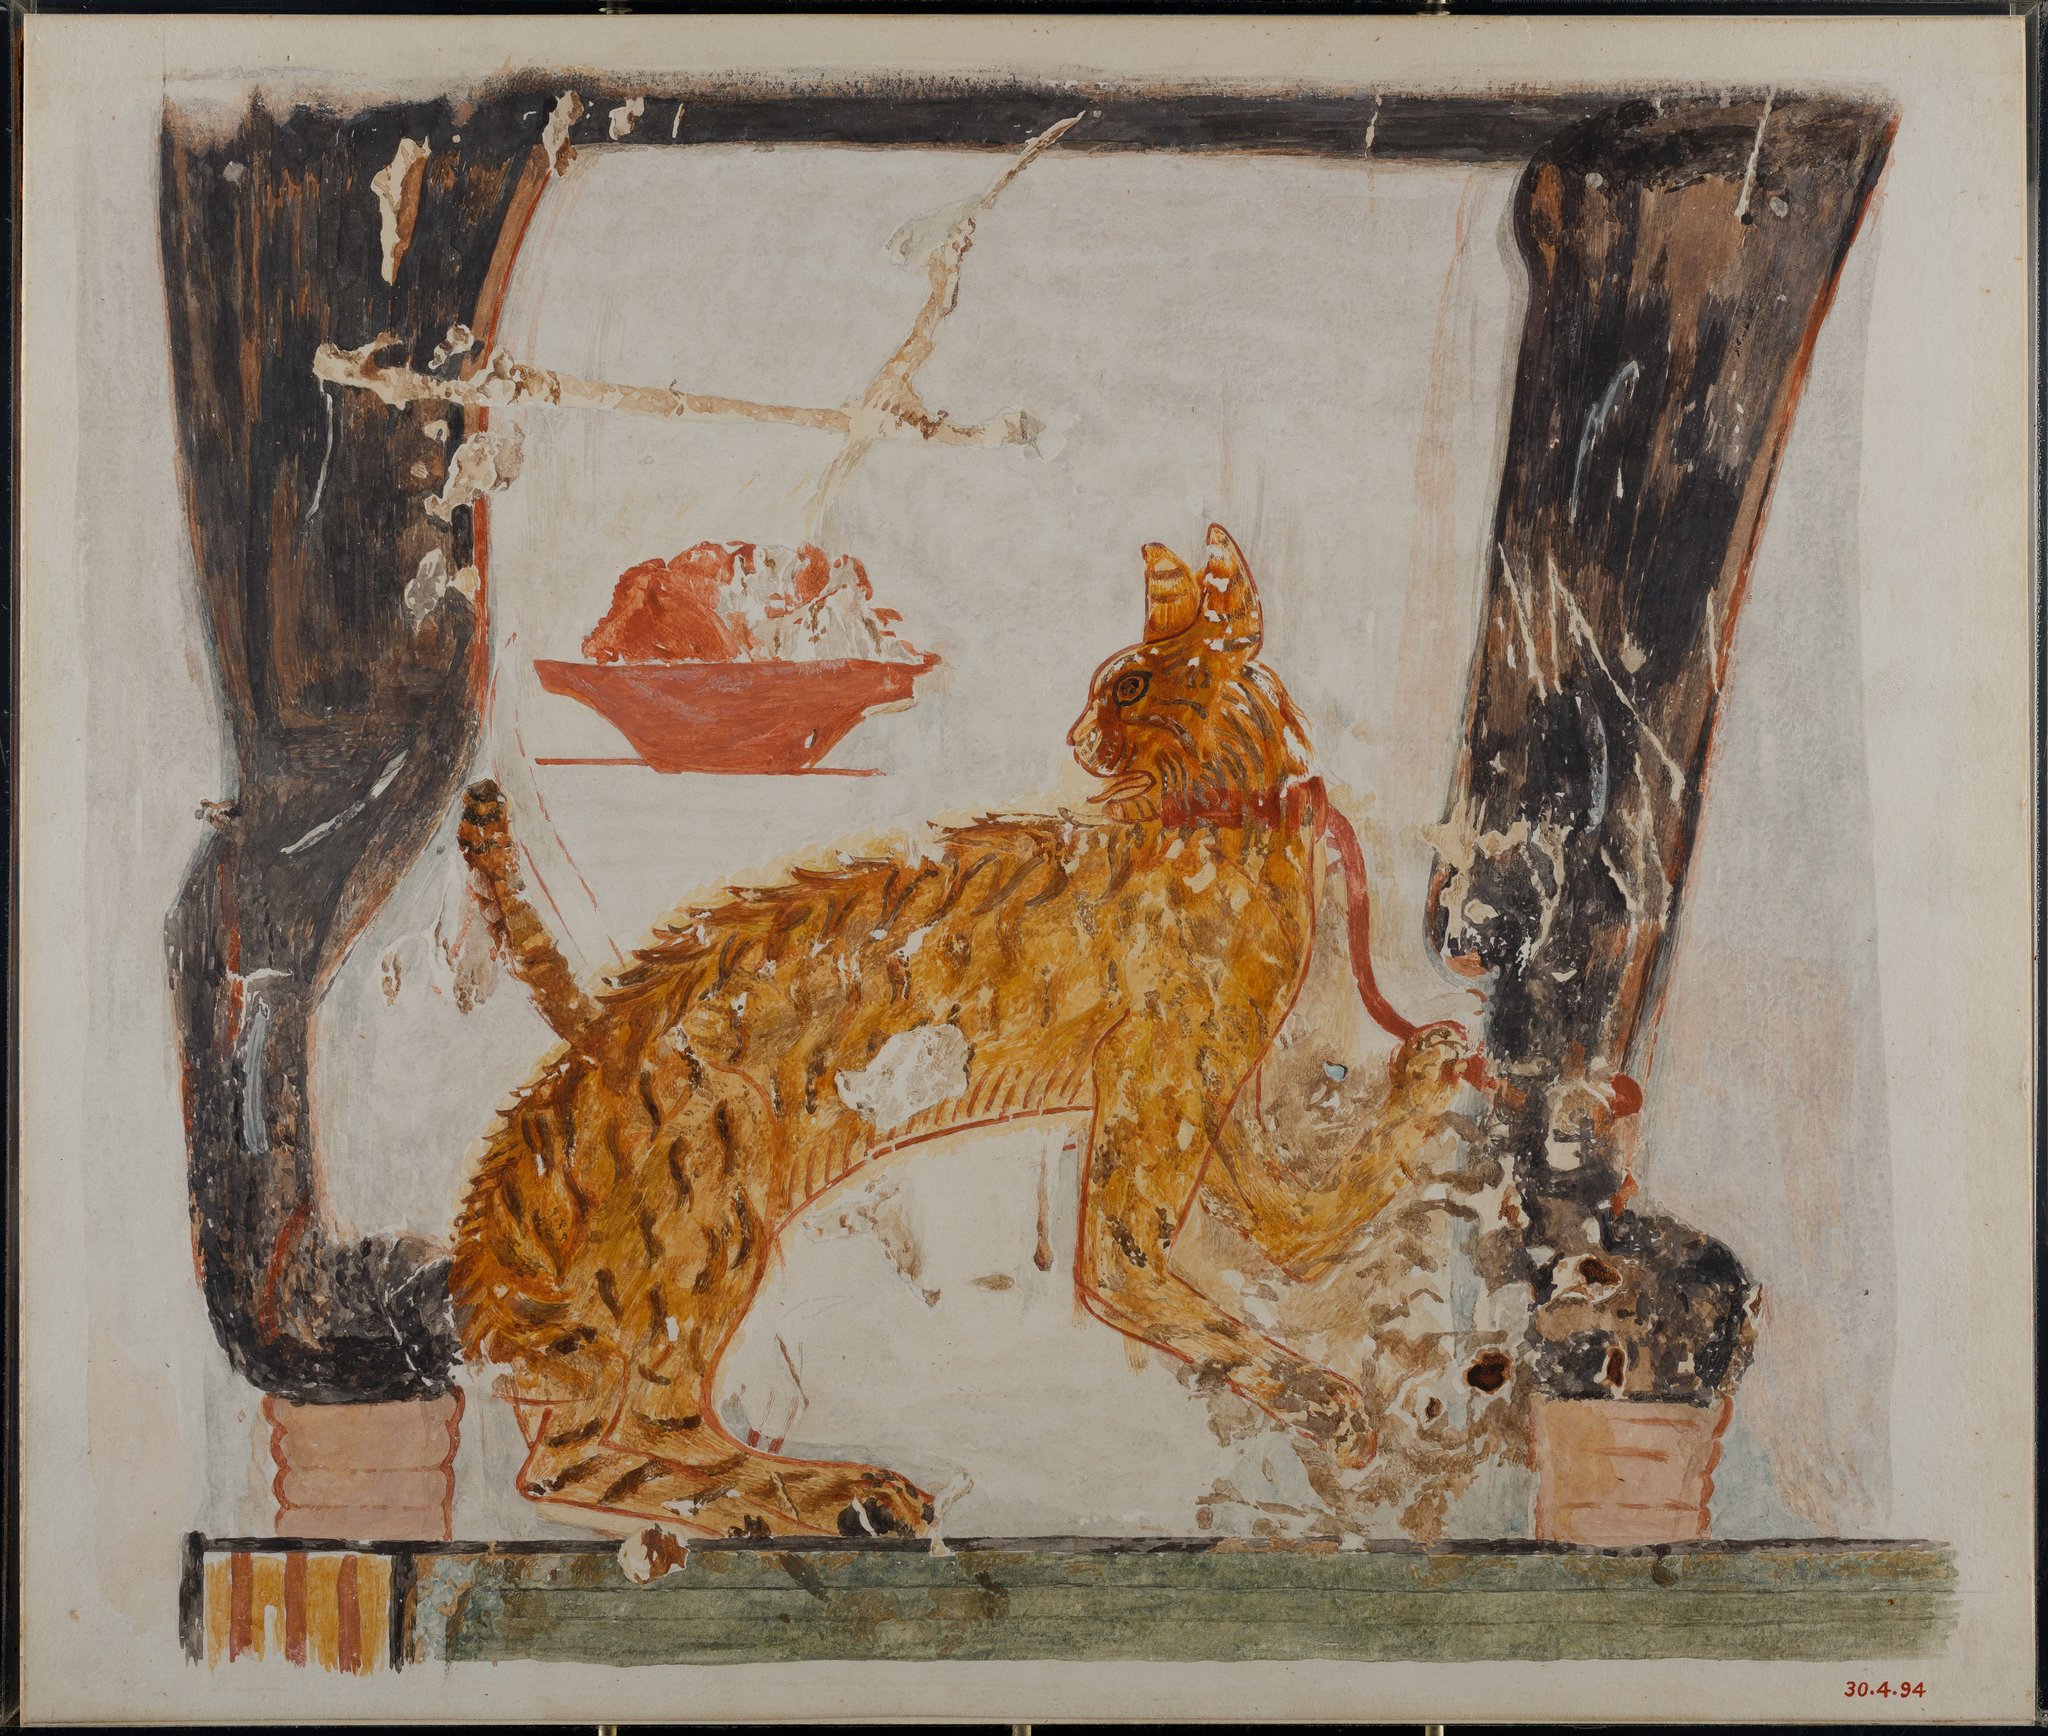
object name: facsimile, may tt 130, cat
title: Cat Seated under a Chair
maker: hugh r. hopgood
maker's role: artist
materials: paper, paint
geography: egypt